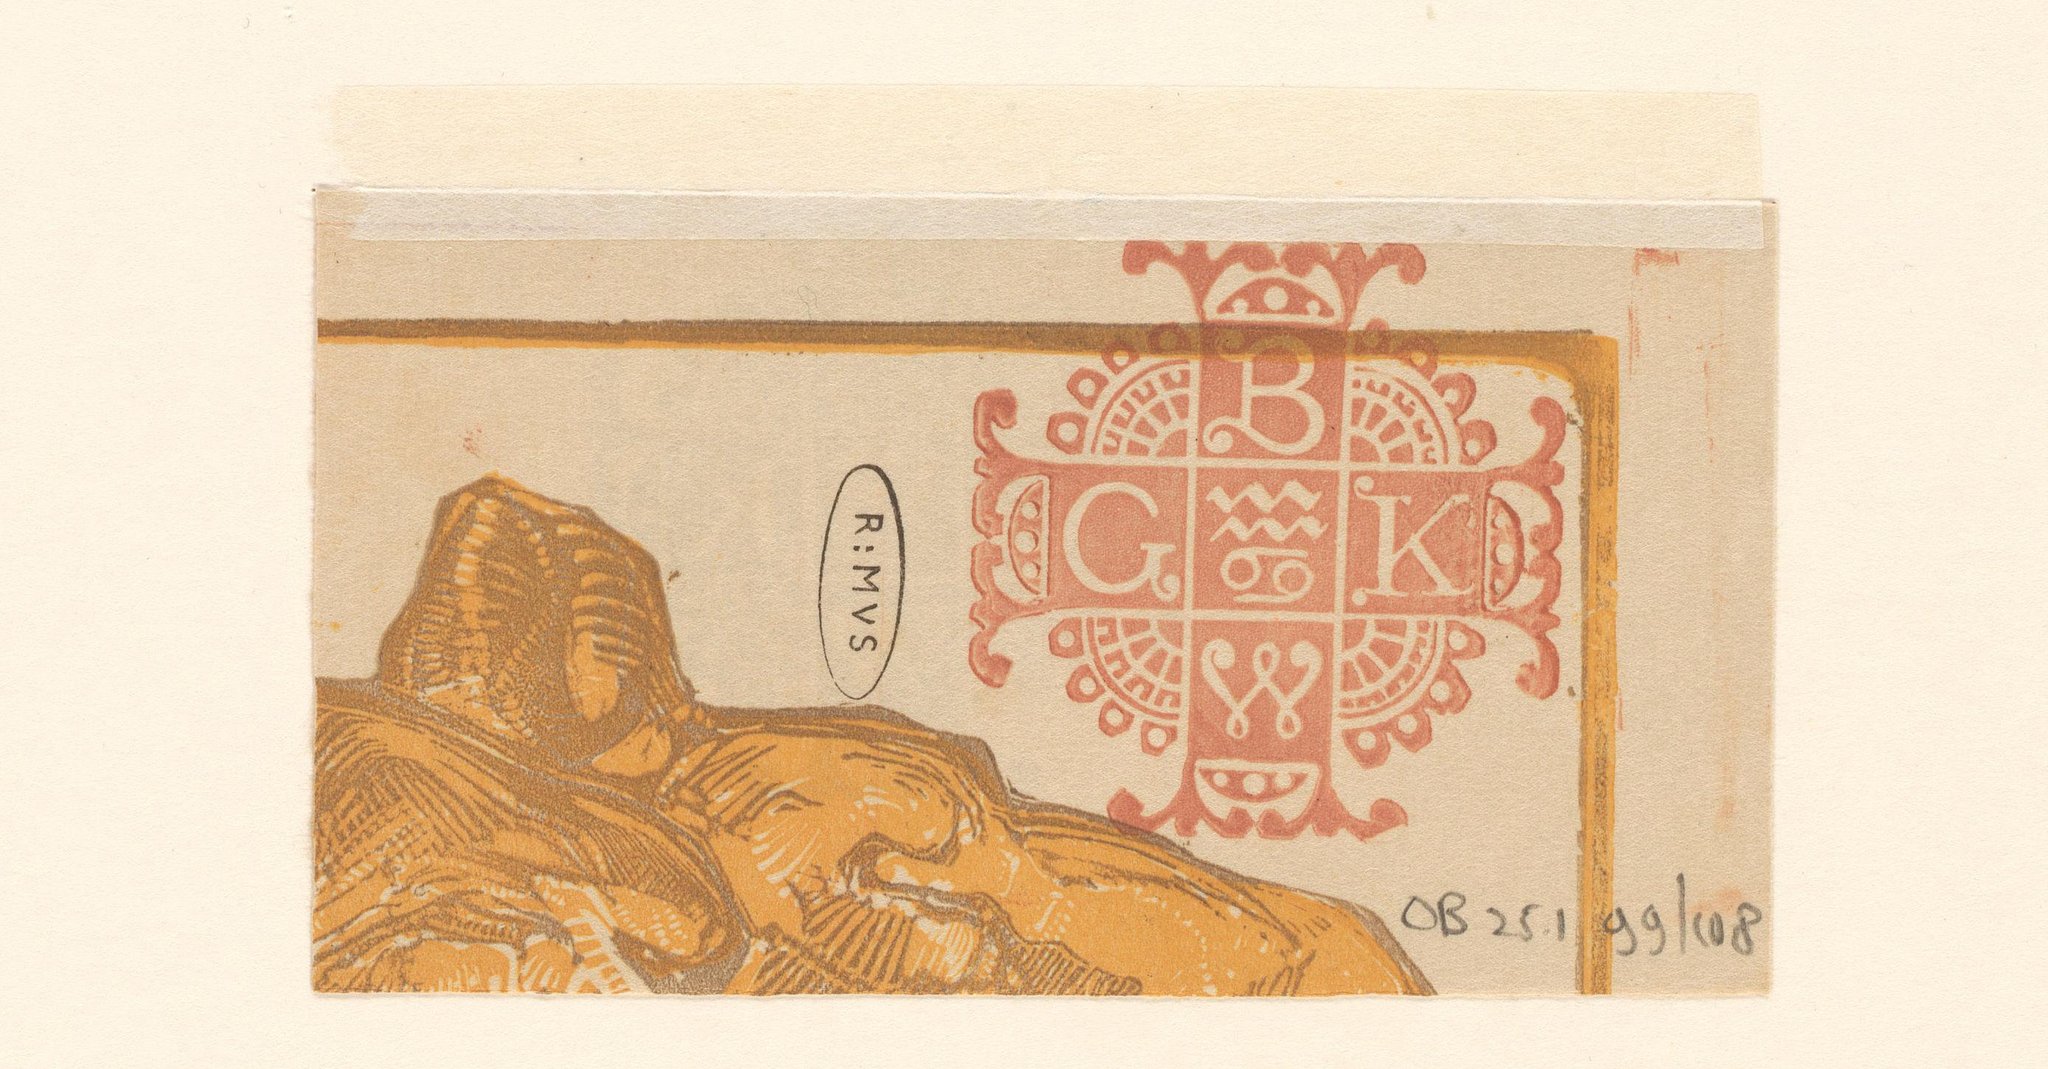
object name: print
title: Vignet met letters B, K, W en G en deel van kop van leeuw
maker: bernard willem wierink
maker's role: draughtsman, print maker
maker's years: 1856-1939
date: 1871-1939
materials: paper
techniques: relief print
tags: beasts of prey, predatory animals: lion, vignette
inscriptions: collector's mark: Lugt 2228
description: Deze prent is vermoedelijk een plaatsnede, ook al wordt in de literatuur veelal gesproken over een houtsnede. Voor zover Wierink zijn prenten in hoogdruk zelf nader heeft omschreven, heeft hij altijd de term 'plaatsnede' gebruikt.